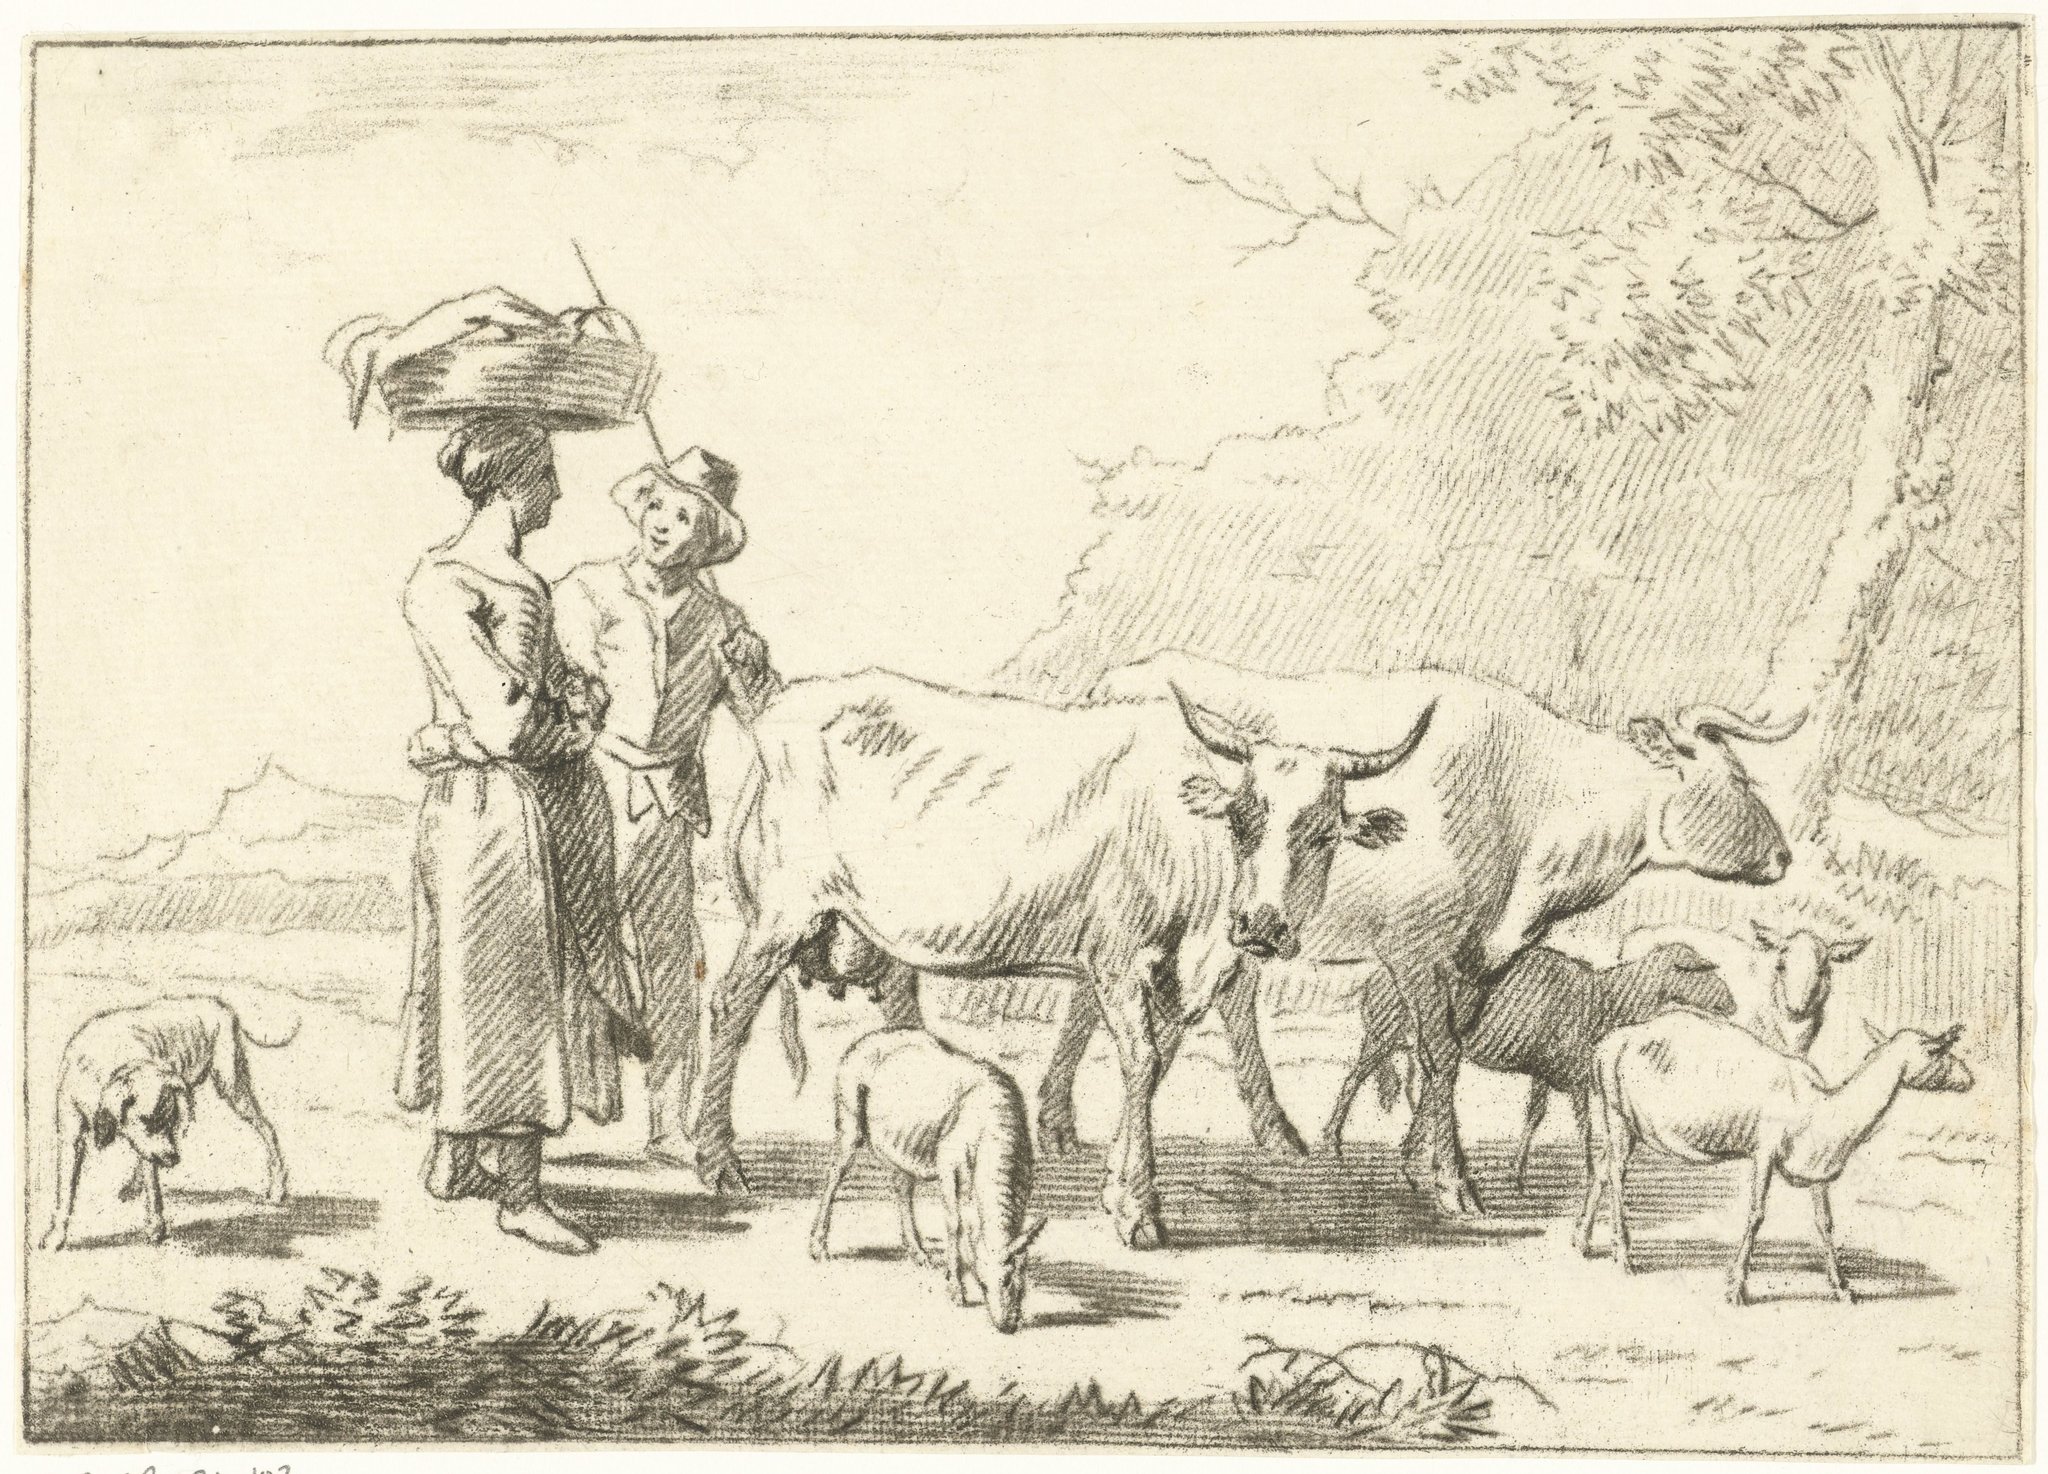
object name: print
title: Herder en een vrouw met koeien en schapen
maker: cornelis van noorde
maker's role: draughtsman, print maker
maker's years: 1731-1795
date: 1768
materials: paper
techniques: printmaking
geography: haarlem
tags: cow, herding, herdsman, herdswoman, shepherd, shepherdess, cowherd, etc., sheep, dog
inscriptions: collector's mark: Lugt 240, inscription: ‘Na een tekening van Berghem, in 't koper gebragt door Corn : van Noorde, 1768’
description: Een herder met een staf en een vrouw met een mand op haar hoofd staan achter twee koeien en vier schapen. Links van hen staat een hond.